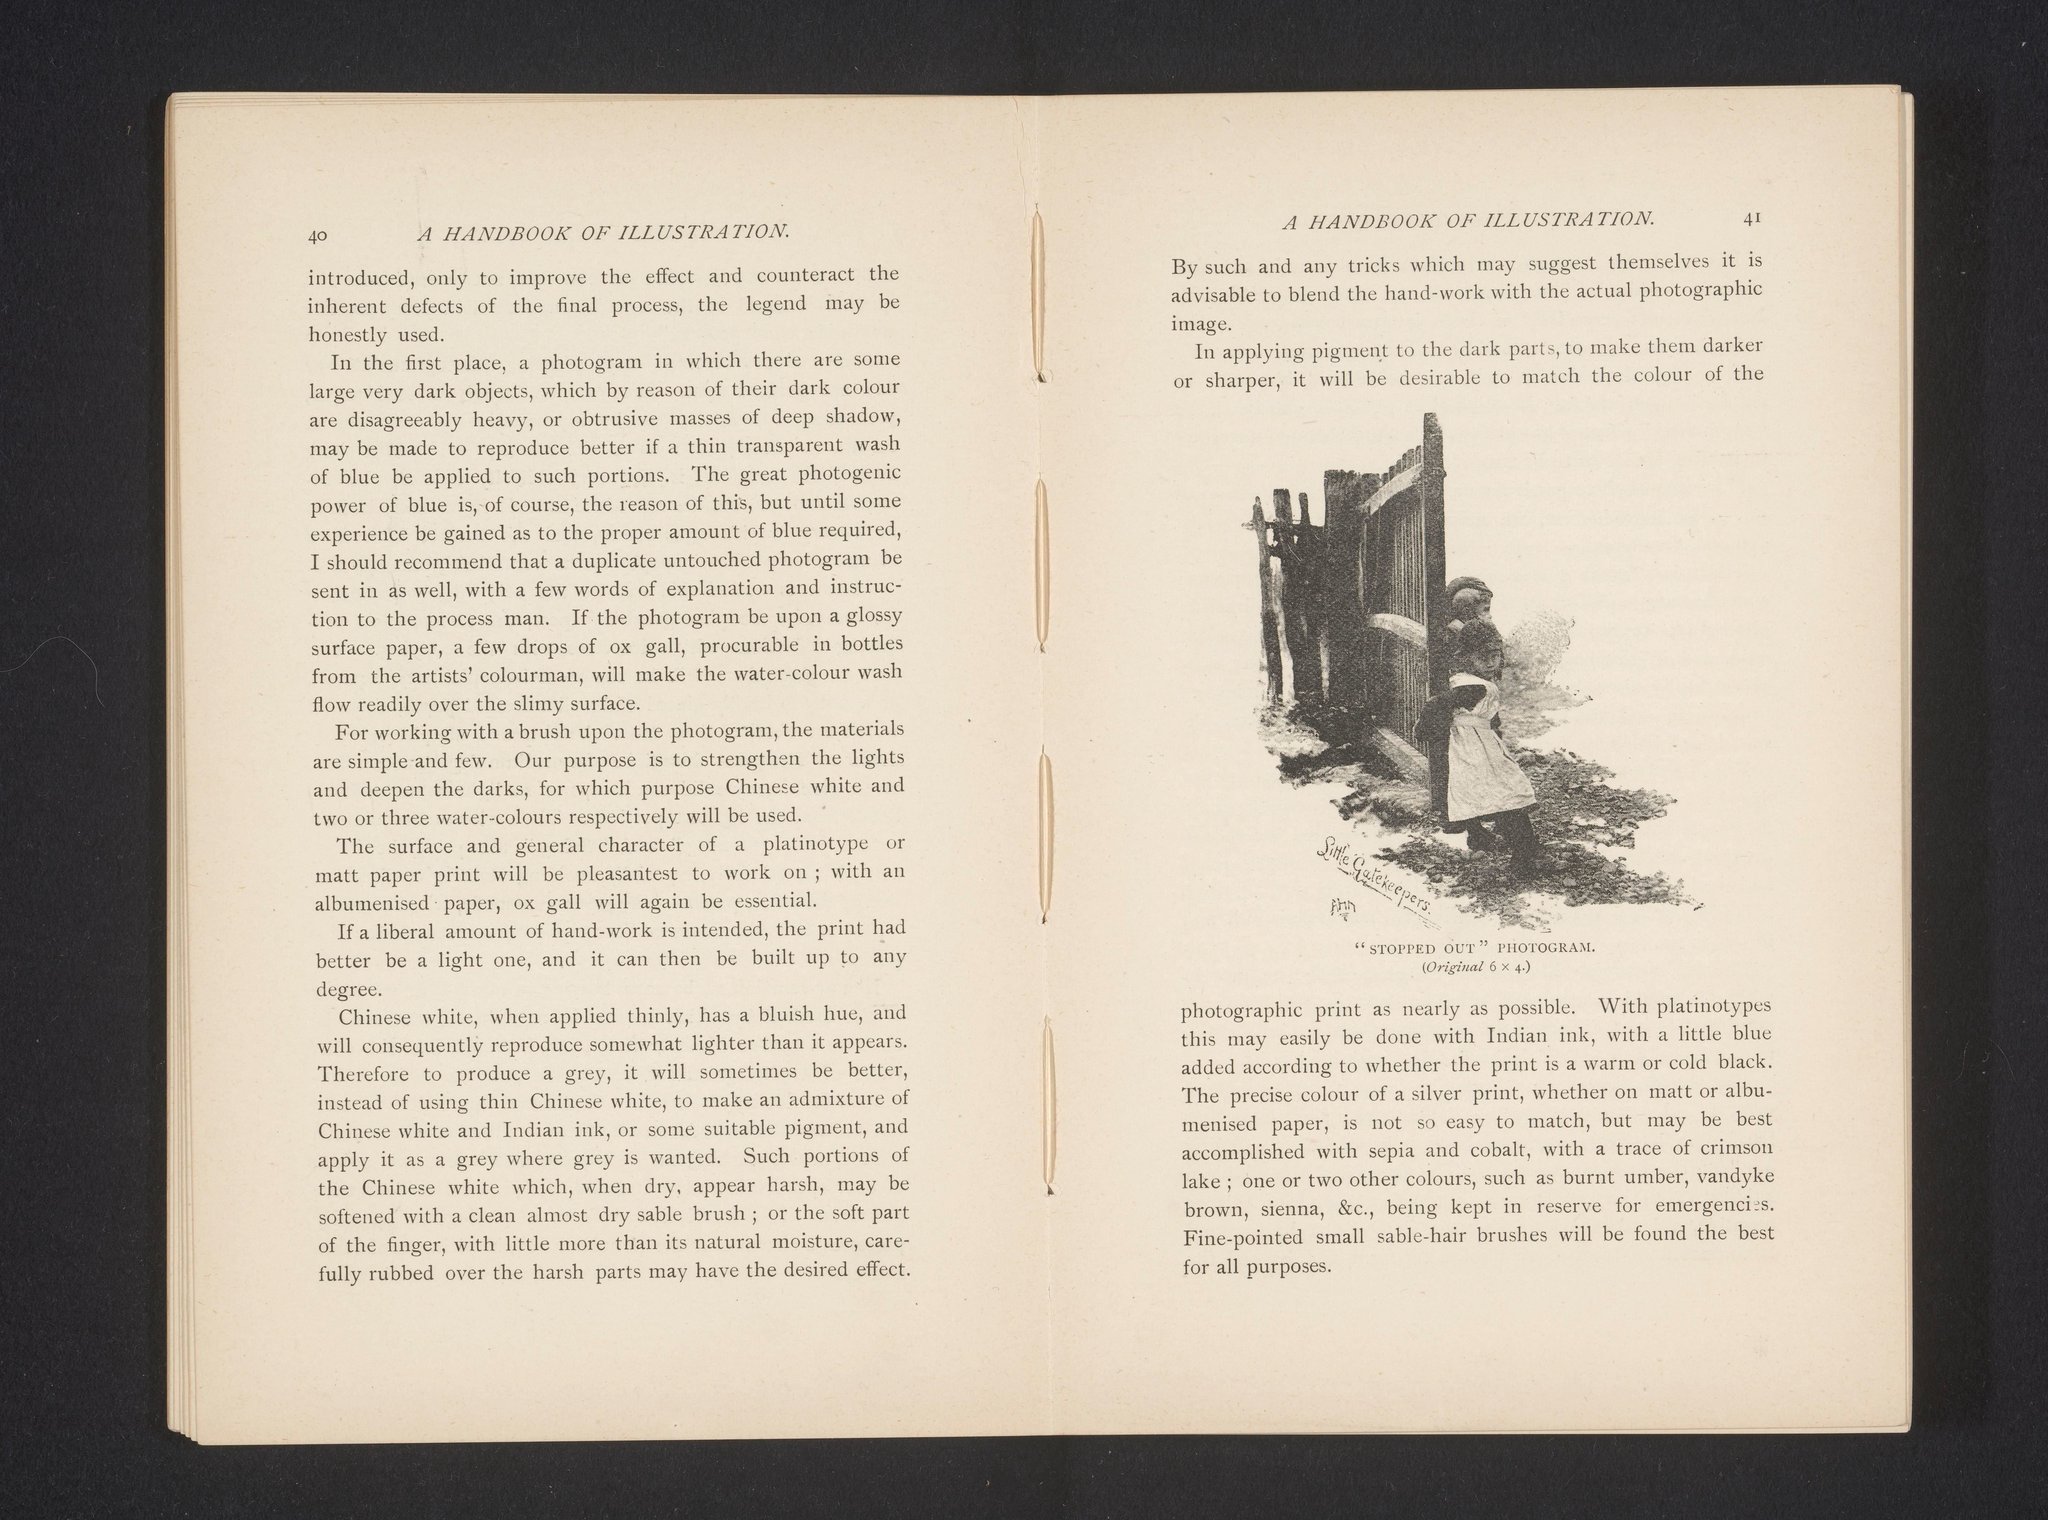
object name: photomechanical print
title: Little gatekeepers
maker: Anonymous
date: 1898-1908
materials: paper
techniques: autotype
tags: gate, entrance, child (at home)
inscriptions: inscription: ‘Ahh’, inscription: ‘“Stopped out” photogram. (Original 6 x 4.)’